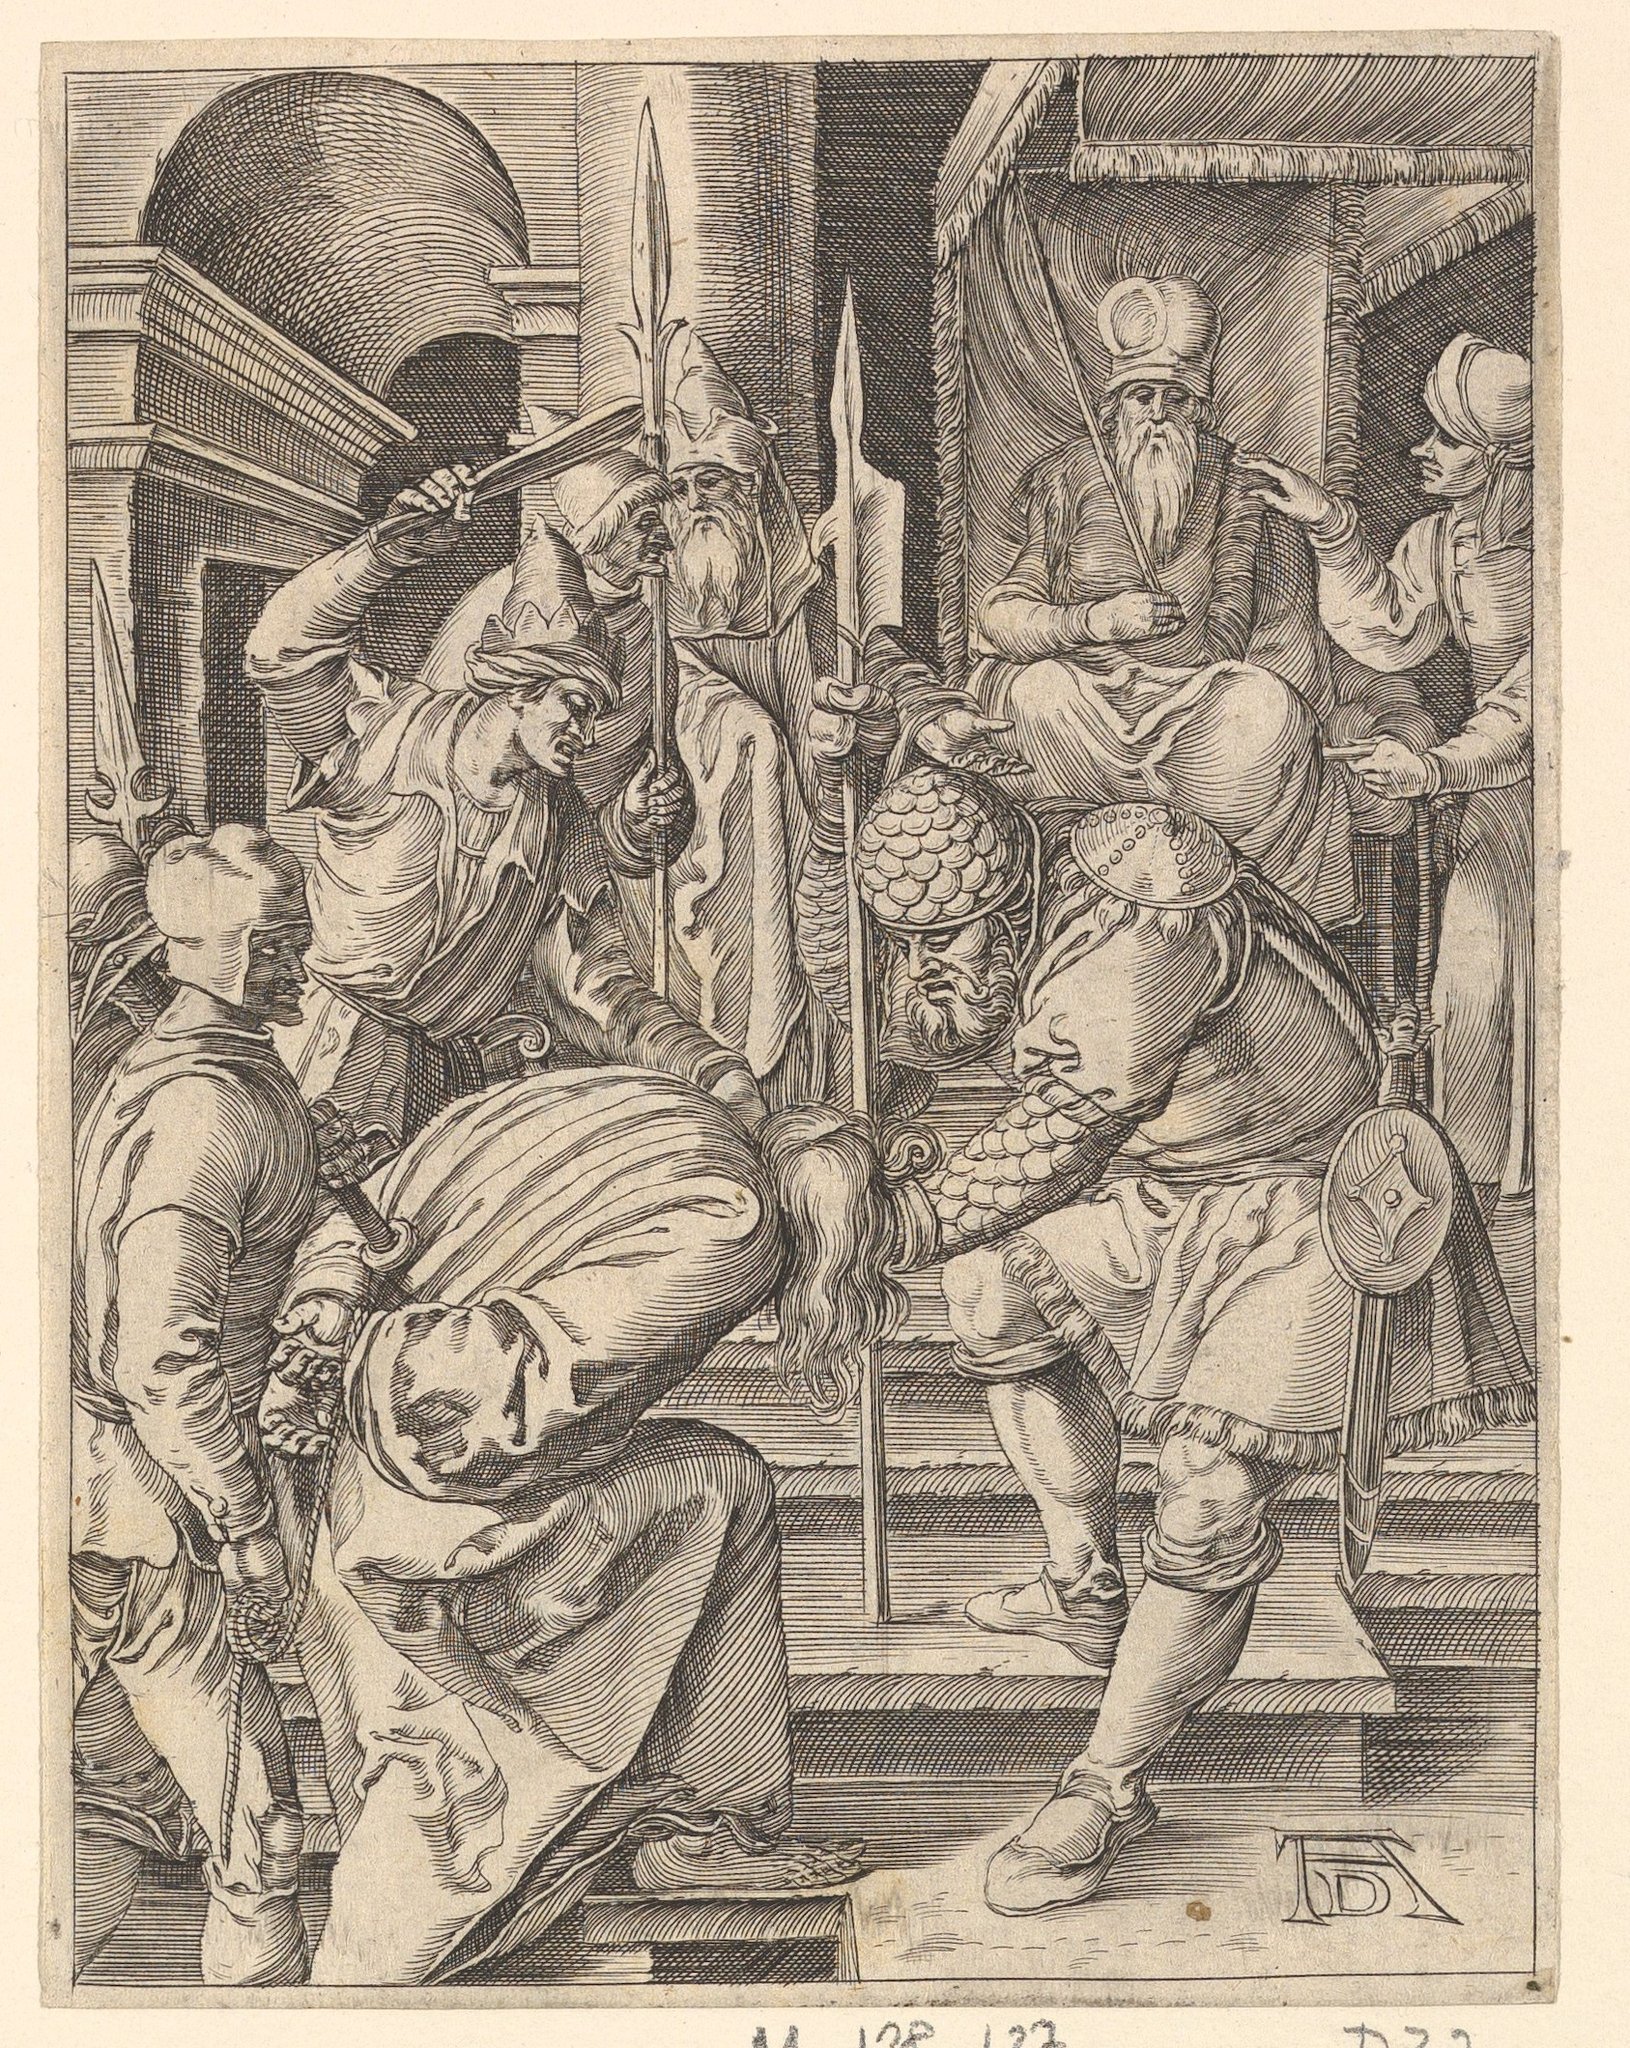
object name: print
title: Engraved copies of The Little Passion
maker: albrecht dürer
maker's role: artist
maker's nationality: german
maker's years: 1471-1528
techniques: engraving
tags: soldiers,spears,swords,men,punishment